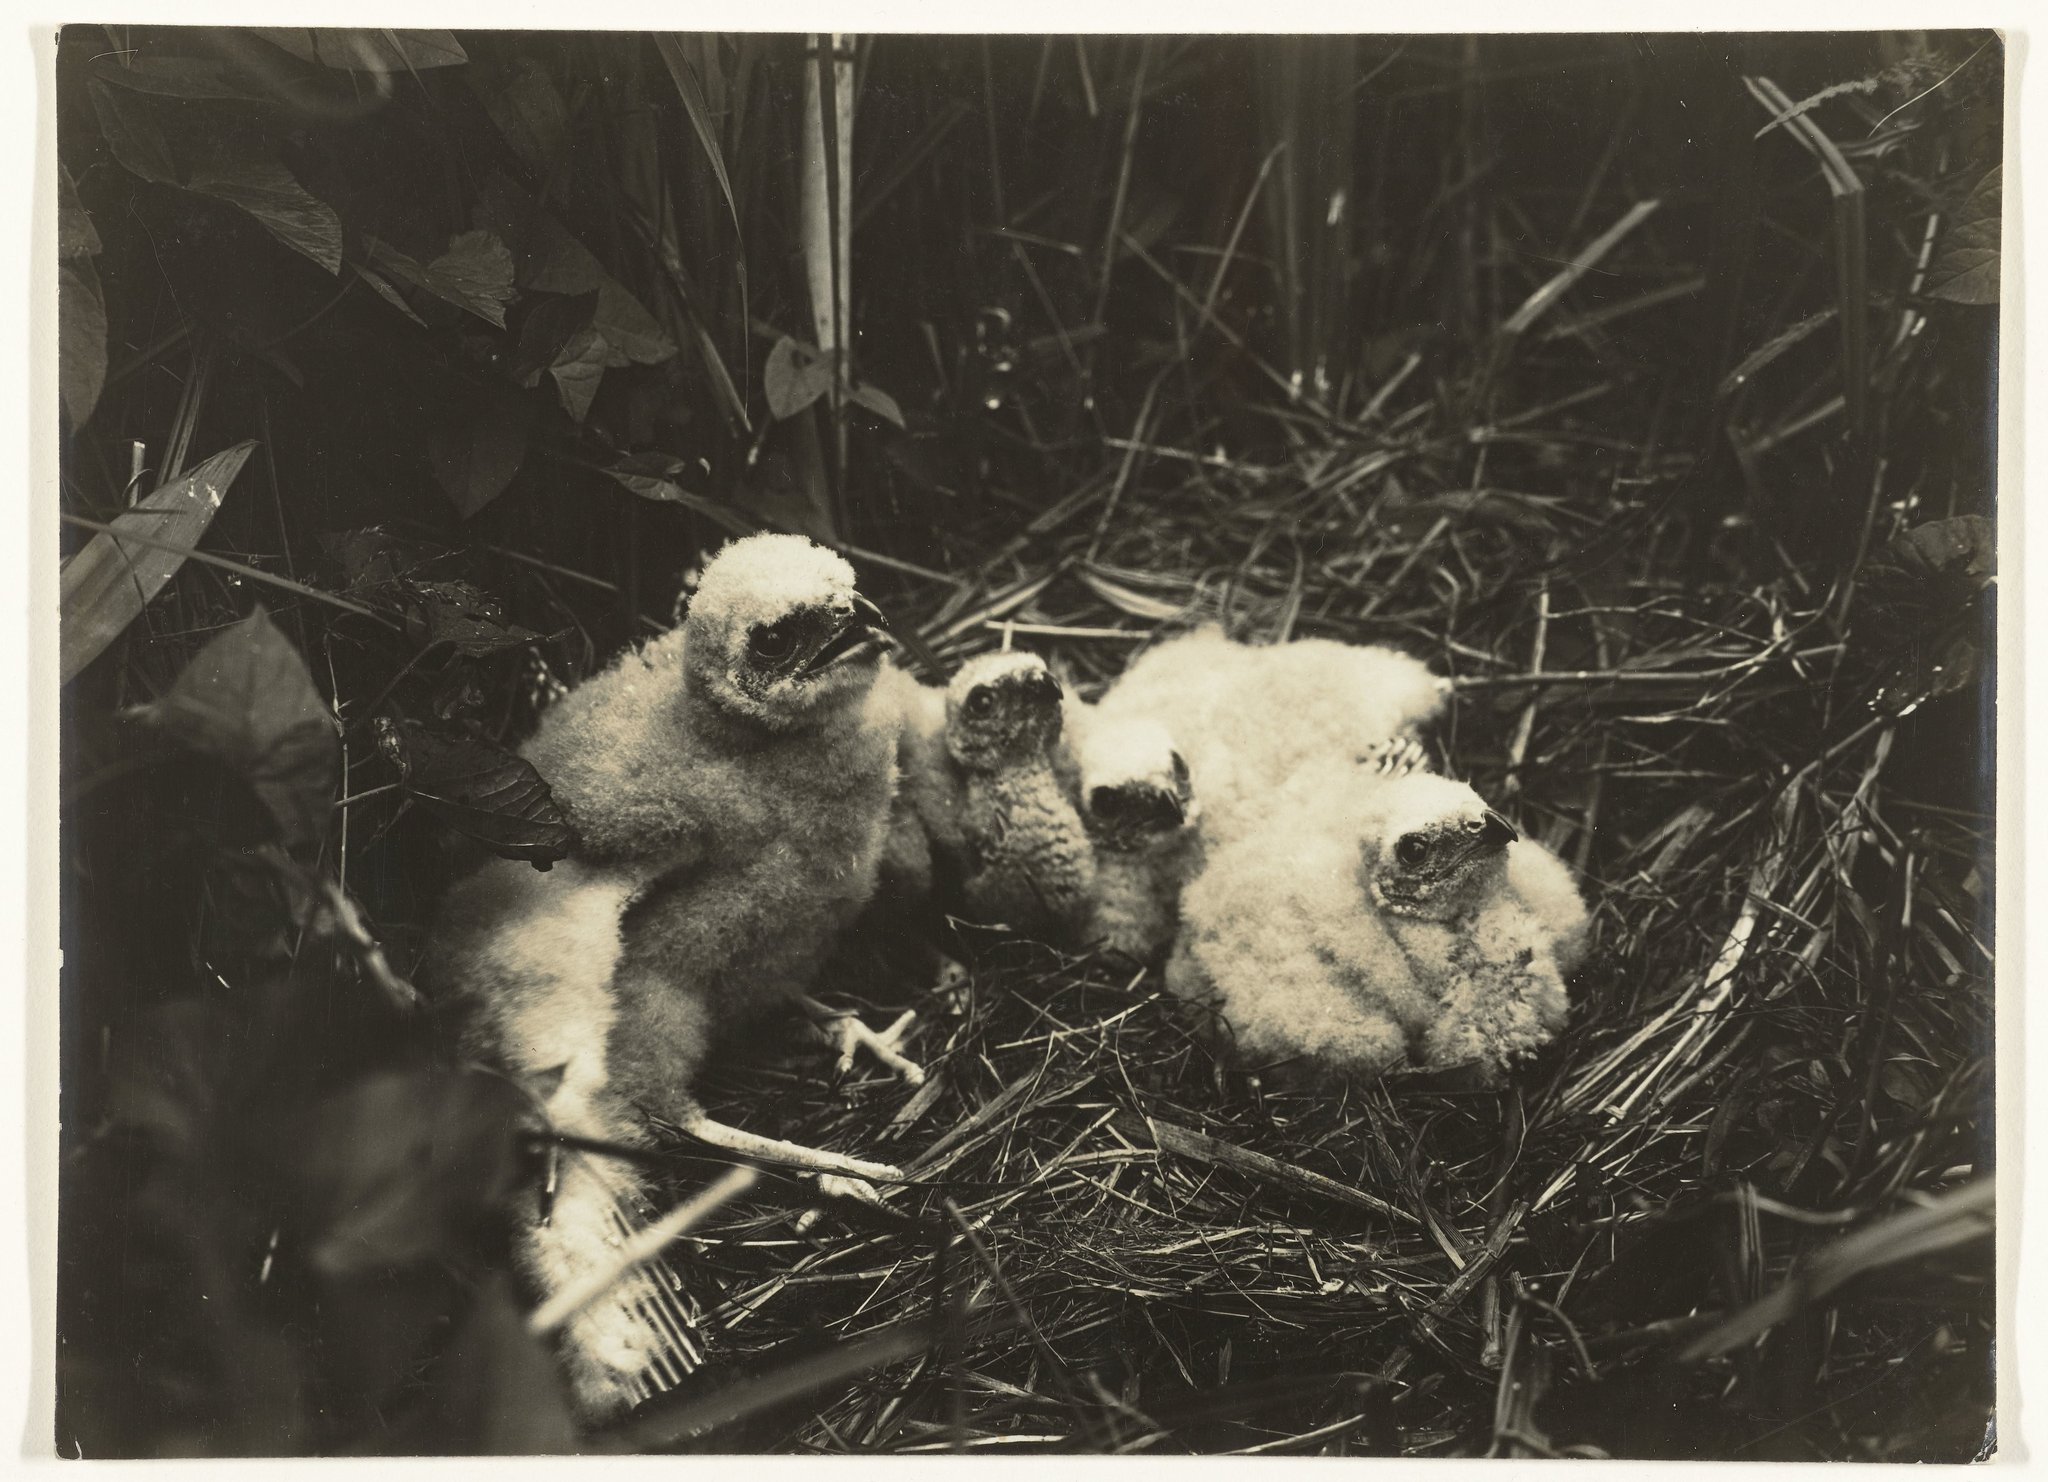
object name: photograph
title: Jongen van de blauwe kiekendief in hun nest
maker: richard tepe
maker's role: fotograaf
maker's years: 1864-1952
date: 1937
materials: paper, photographic support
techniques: gelatin silver print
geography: netherlands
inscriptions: annotation: ‘Horsten [?] donsjongen / van denm Blauwen Kuikendief [in andere hand: opgenomen / Zwartsluis Juni 1937 [...]]’, signature: ‘foto / R Tepe’